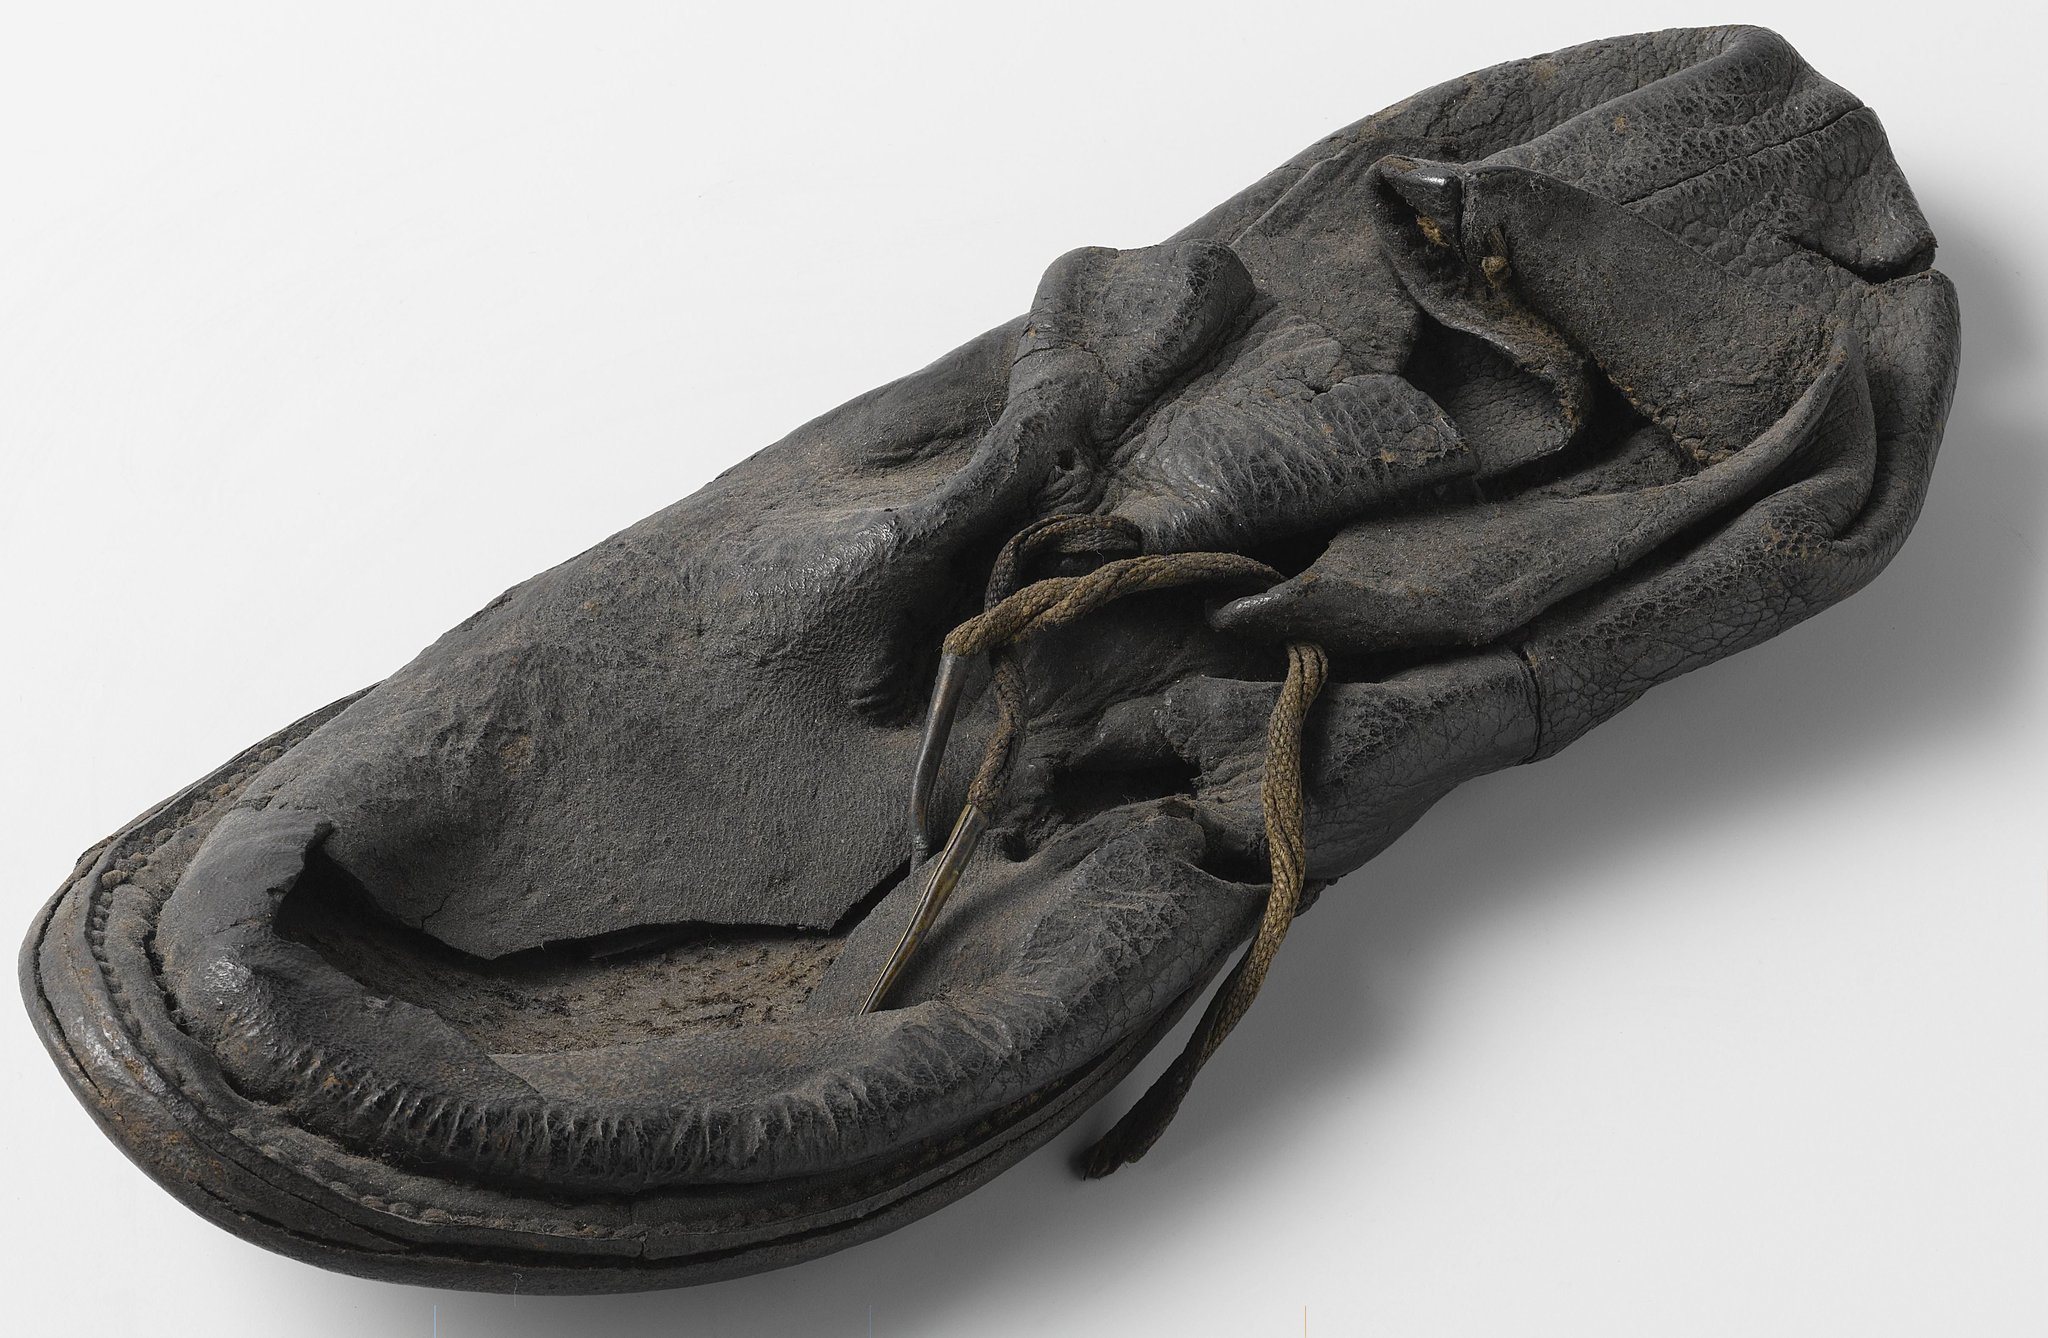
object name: shoe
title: Linkerschoen, maat 34, randgenaaid en met bandsluiting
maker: Anonymous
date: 1590-1596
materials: leather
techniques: cutting, sewing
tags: willem barendsz., amsterdam, jacob van heemskerck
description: Linkerschoen, maat 34, randgenaaid en met bandsluiting. Het voorblad en kwartieren zijn gemaakt van geitenleer, de rand van kalfsleer. Langs de binnenzijde van de kwartieren is een touwtje opgenaaid en over de zijnaden zijn verbindingsstukjes opgenaaid. De steken van de zoolnaad zijn 3 mm lang. Een hielvoering is niet toegepast en ook geen tussenzool of kurk/hout-vulling.